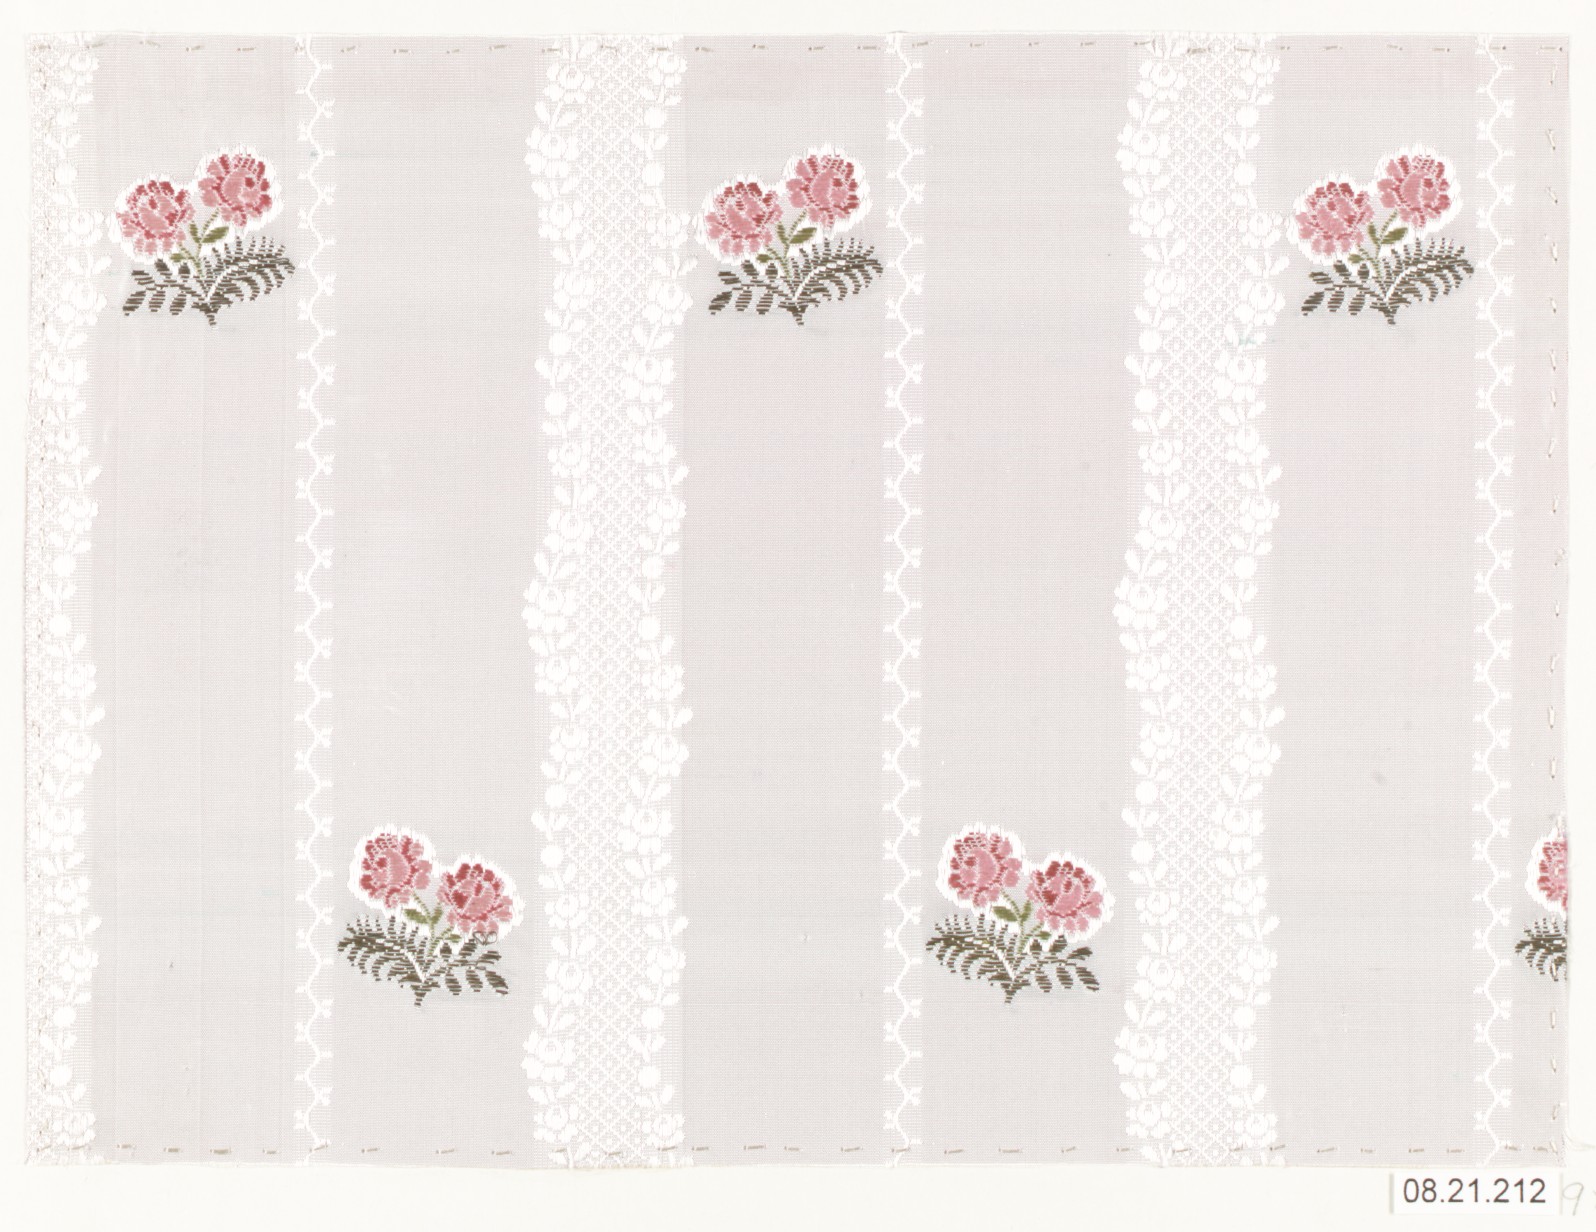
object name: textile sample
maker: Anonymous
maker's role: designer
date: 1900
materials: silk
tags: flowers